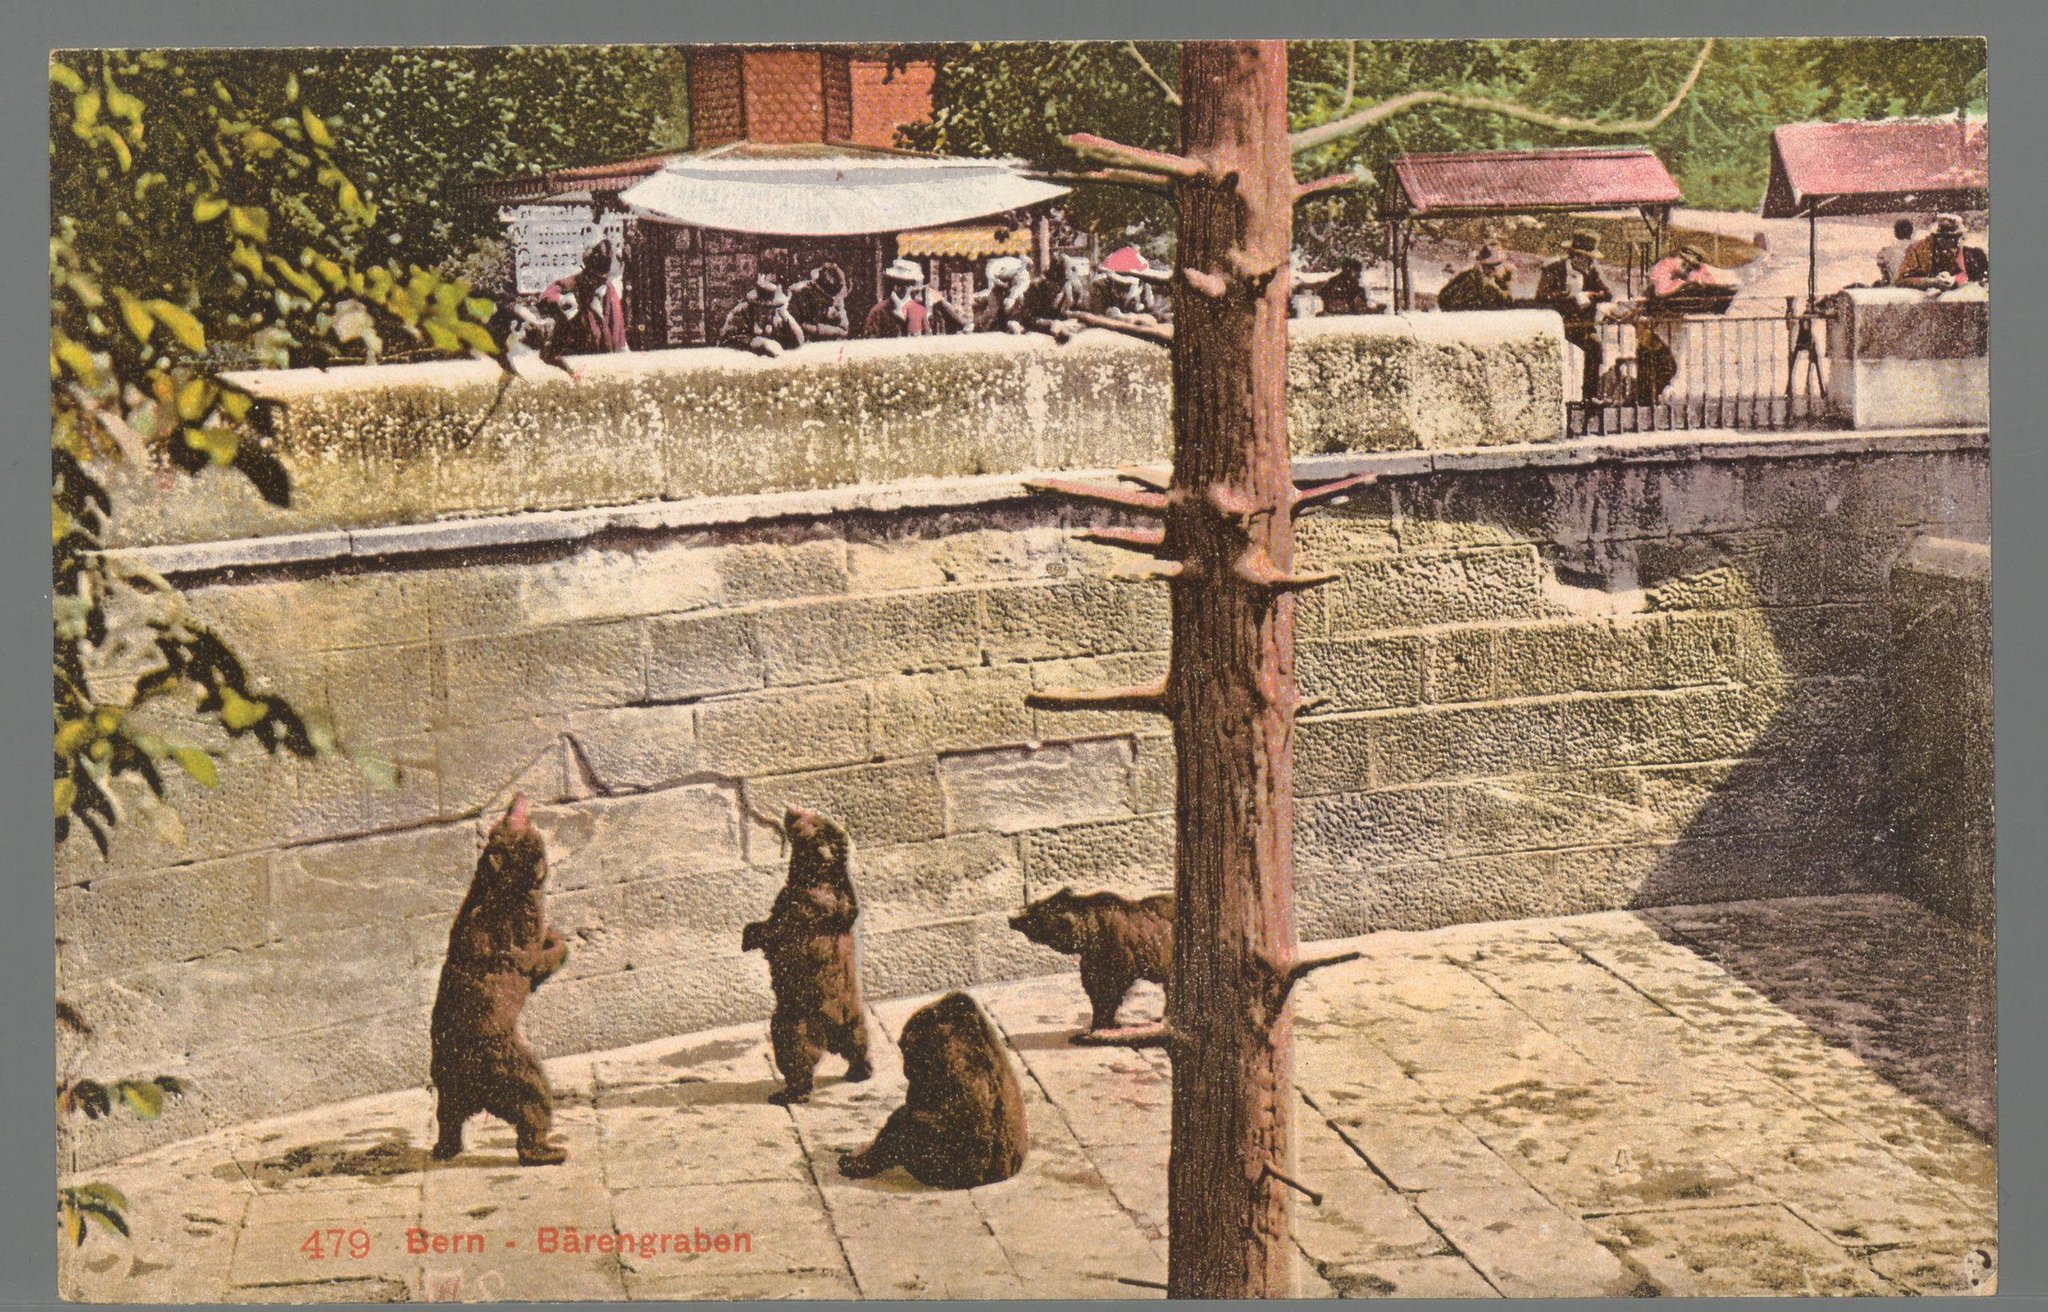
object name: photomechanical print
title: Bern. Bärengraben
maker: Anonymous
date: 1905-1930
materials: cardboard, photographic process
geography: zurich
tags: public gardens, park (+ city(-scape) with figures, staffage), bear-pit, beasts of prey, predatory animals: bear